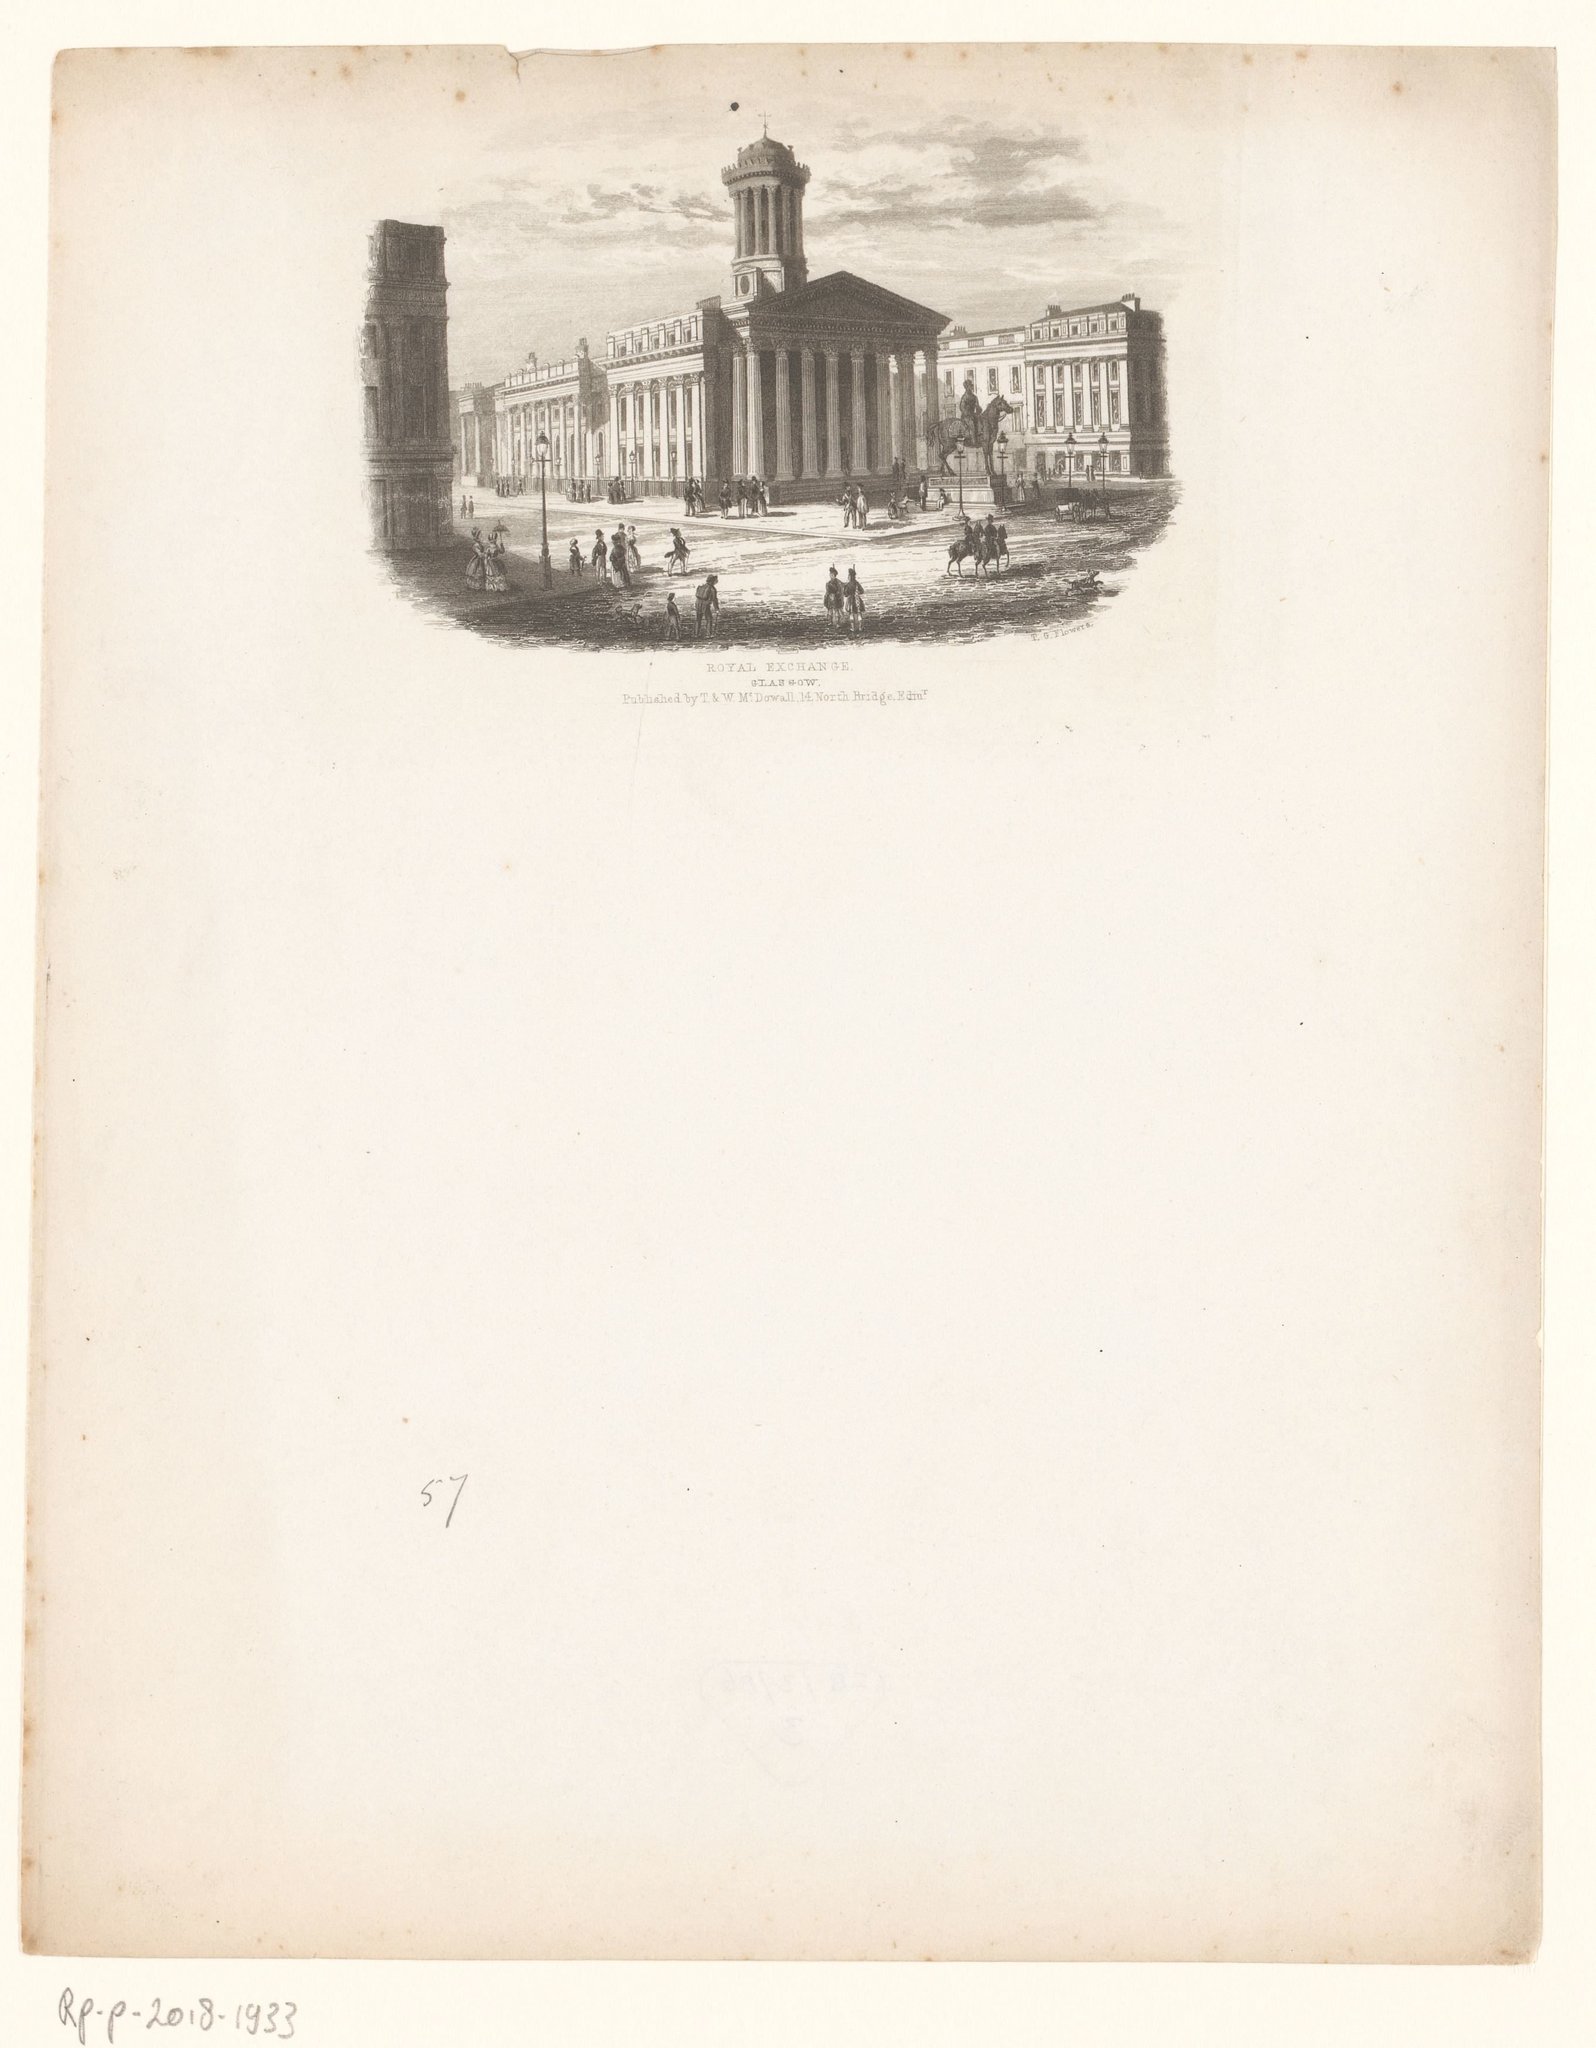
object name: print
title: Gezicht op het beursgebouw, te Glasgow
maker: thomas flowers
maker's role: print maker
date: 1650-1749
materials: paper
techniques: engraving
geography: edinburgh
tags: exchange, bourse, glasgow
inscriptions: collector's mark: Lugt 2228